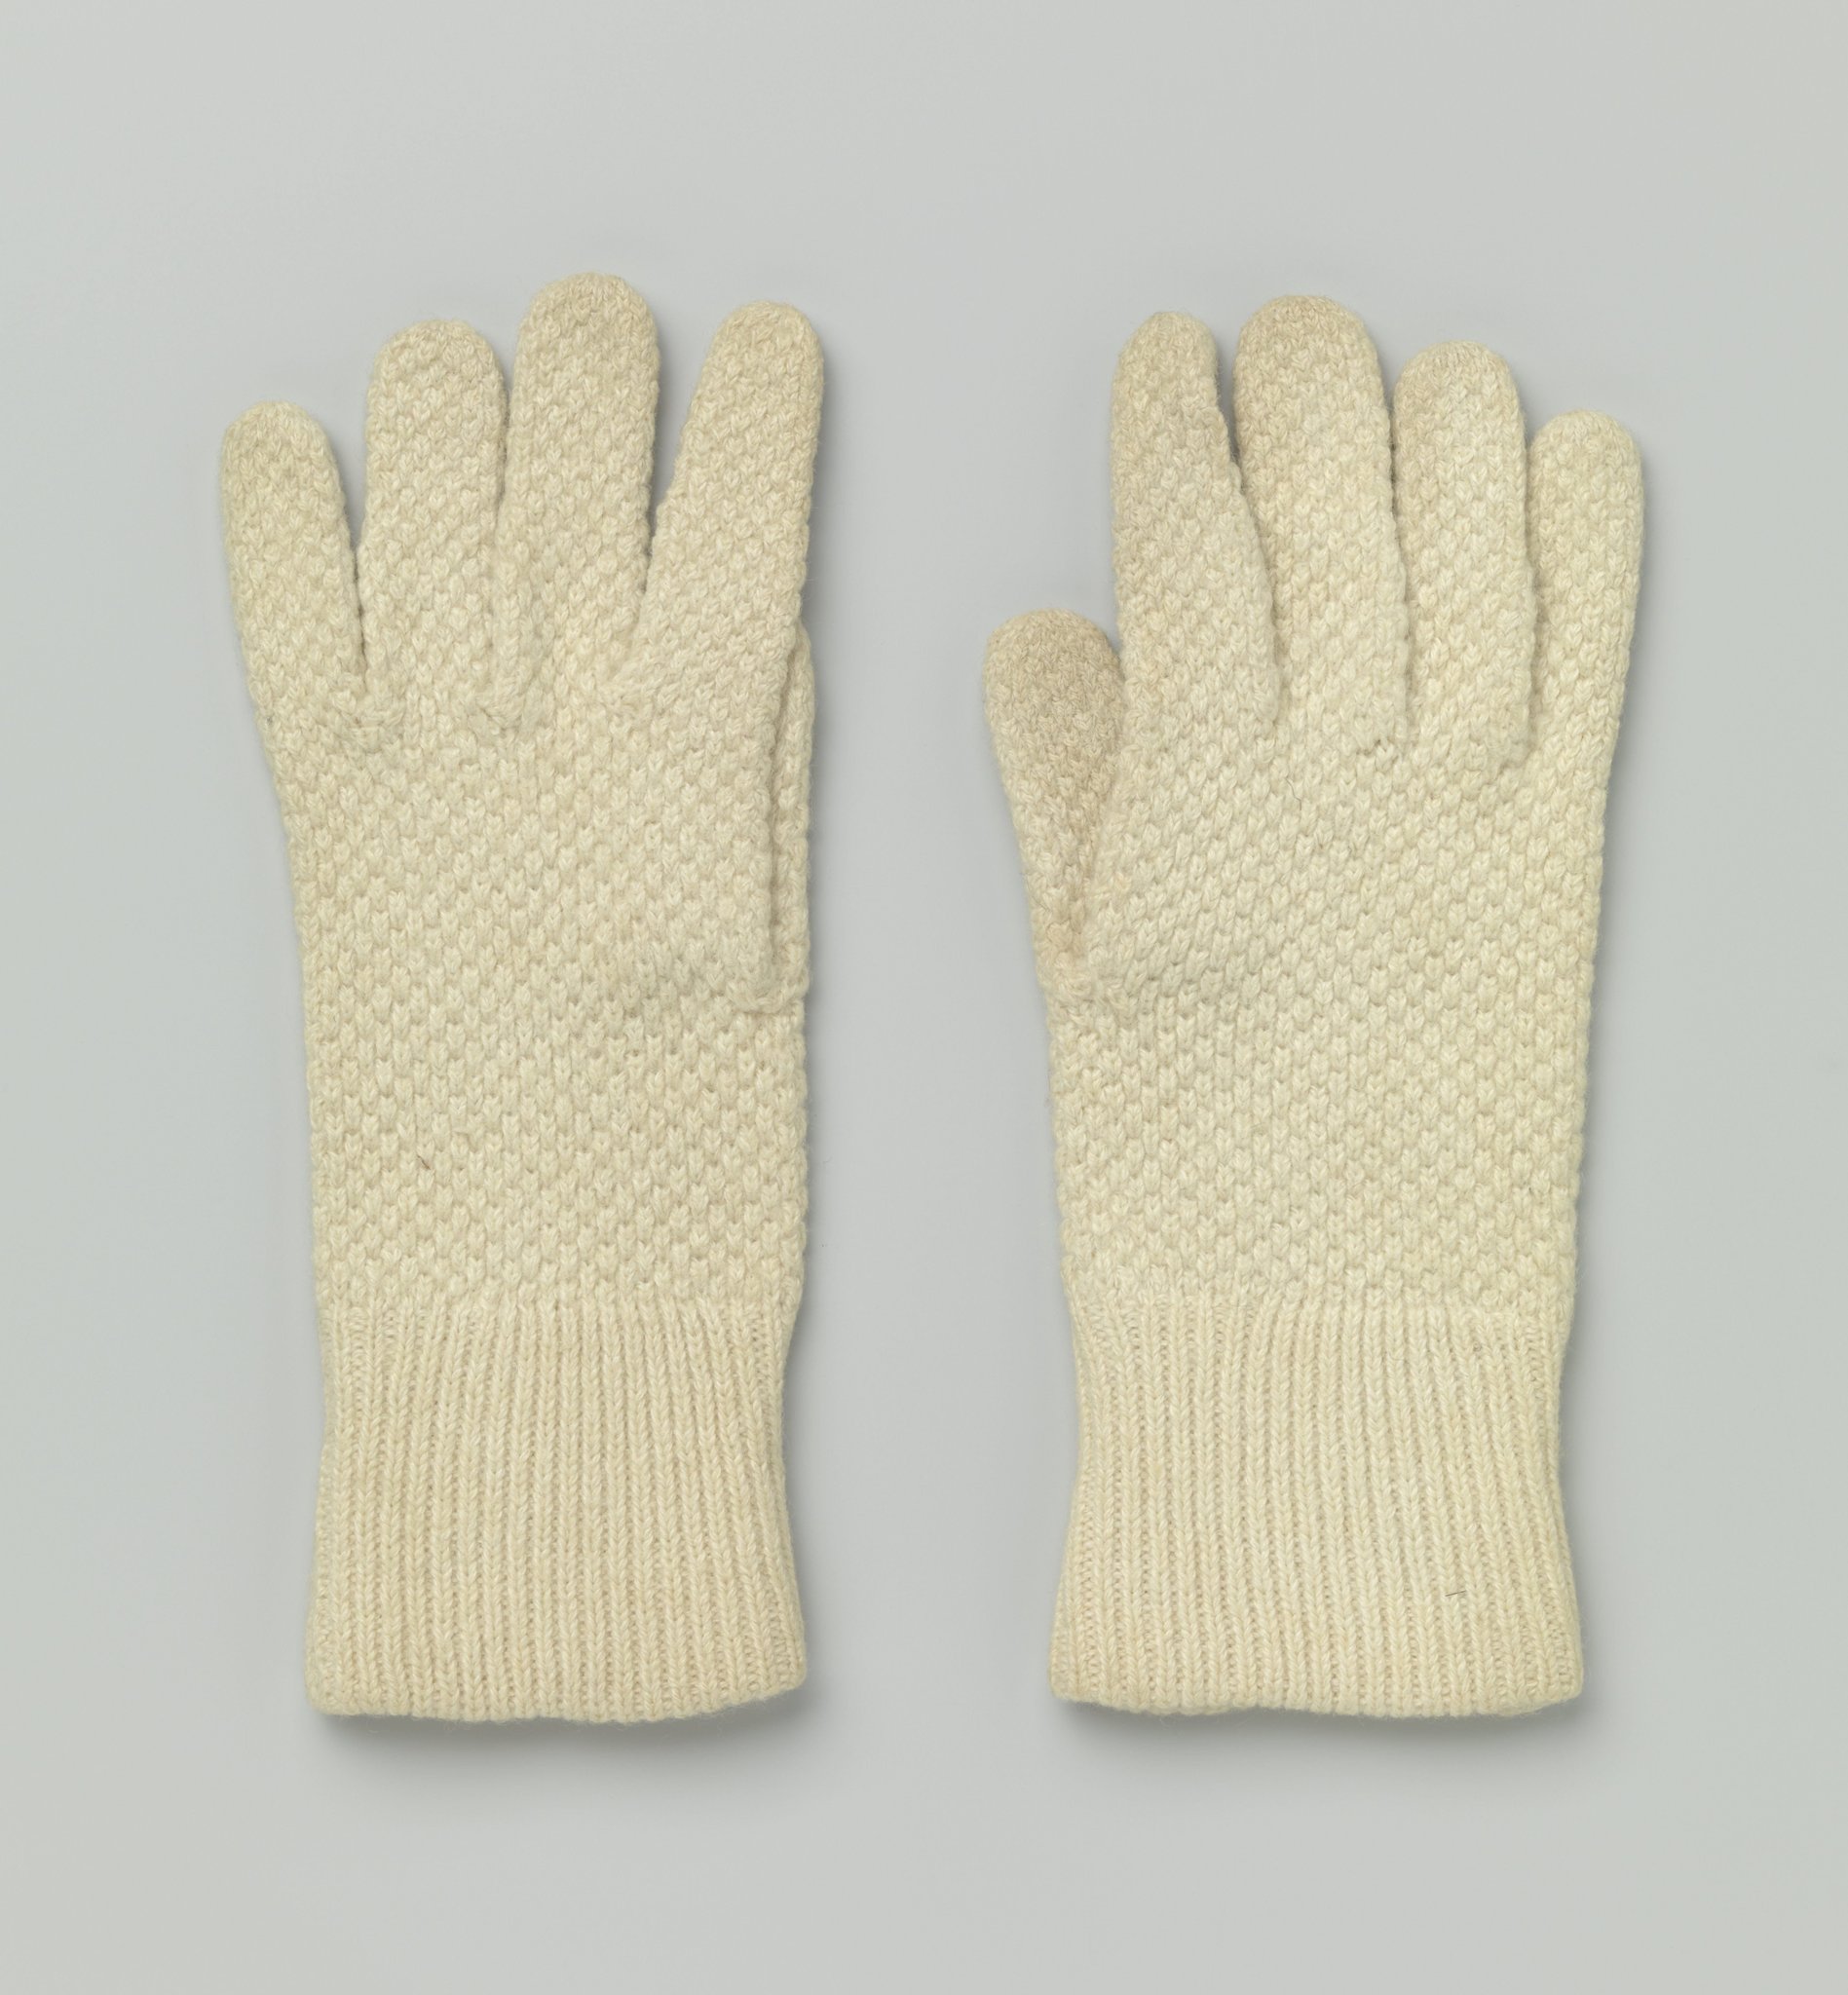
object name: menswear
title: Handschoen van witte wol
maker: Anonymous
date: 1900-1920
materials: wool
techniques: knitting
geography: amsterdam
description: Paar heren schaatshandschoenen van witte gebreide wol, z.g. "Ringwood". Model: Kort, met dubbel en gesloten polsboord. Patroon: Gerstenkorrel-Breisel.